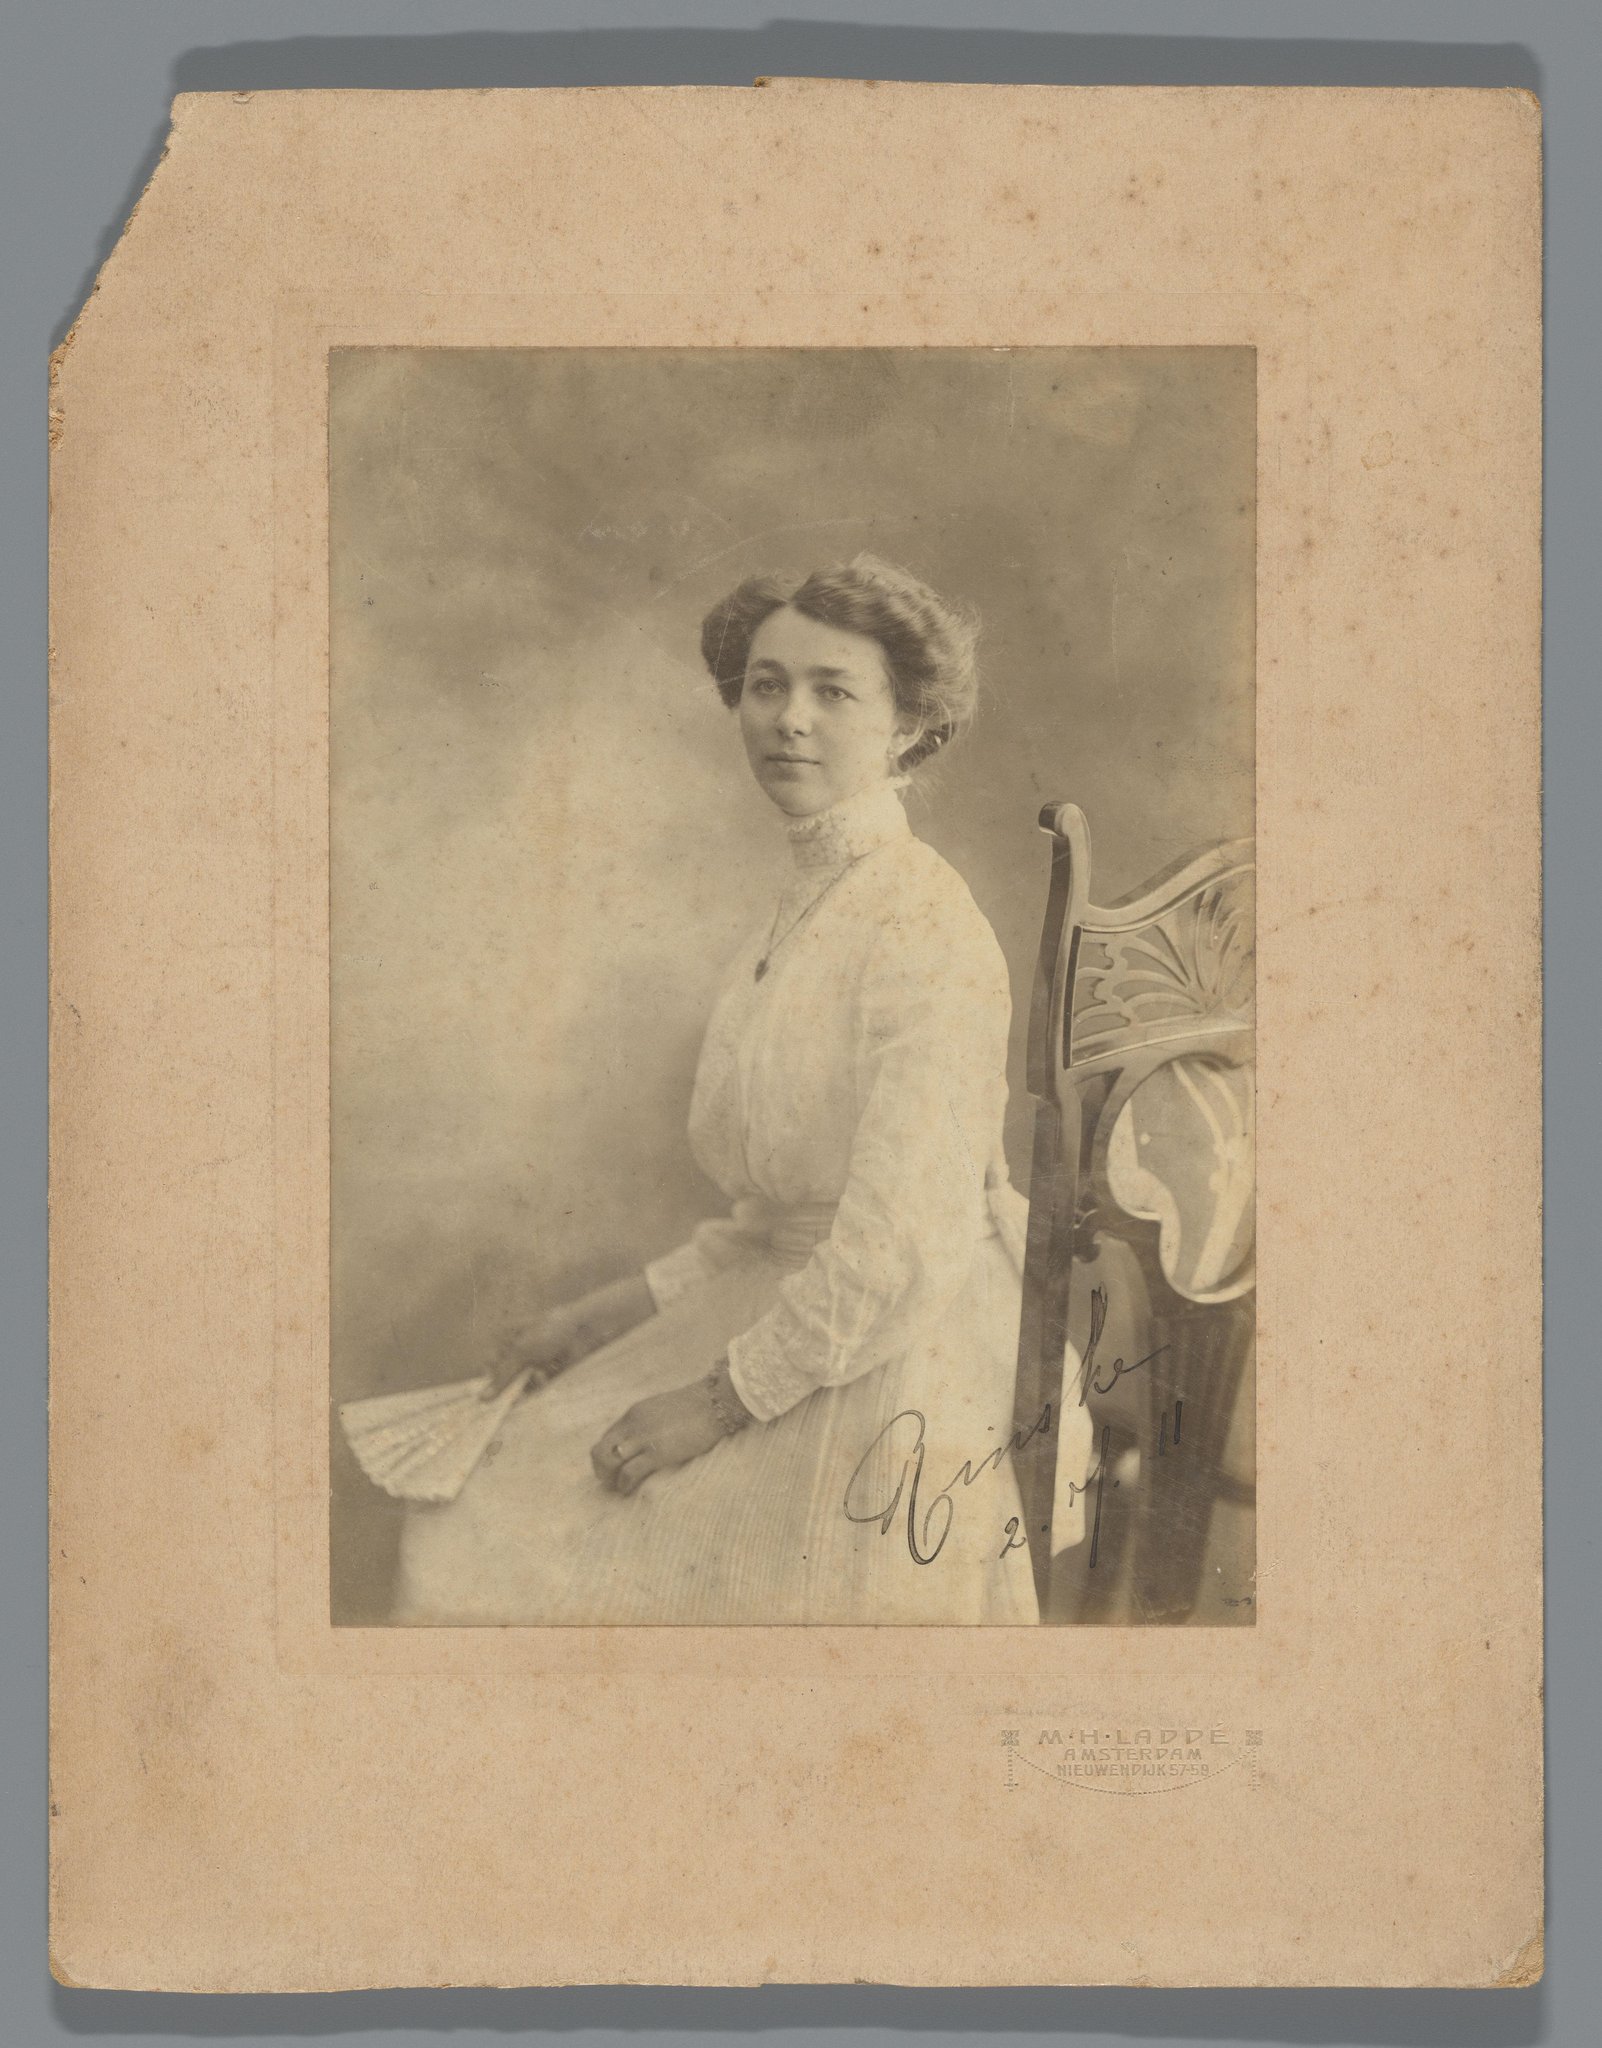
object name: photograph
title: Portret van een onbekende vrouw, aangeduid als Rinske, met een waaier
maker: machiel hendricus laddé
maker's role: fotograaf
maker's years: 1866-1932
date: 1911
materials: paper, cardboard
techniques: matte daylight collodion silver print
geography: amsterdam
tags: historical persons - bb - woman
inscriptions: address: ‘M.H. LADDÉ/ AMSTERDAM/ NIEUWEDIJK 57-59’, inscription: ‘Rinske/ 2.7.11’, inscription: ‘V Slooten/ 1 med gr I/ gekleur’